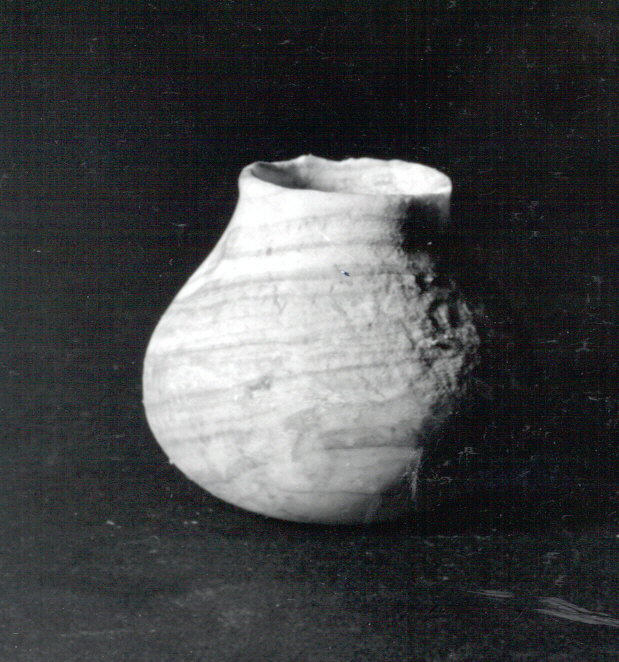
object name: jar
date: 7000-5001 BCE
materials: alabaster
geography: syria